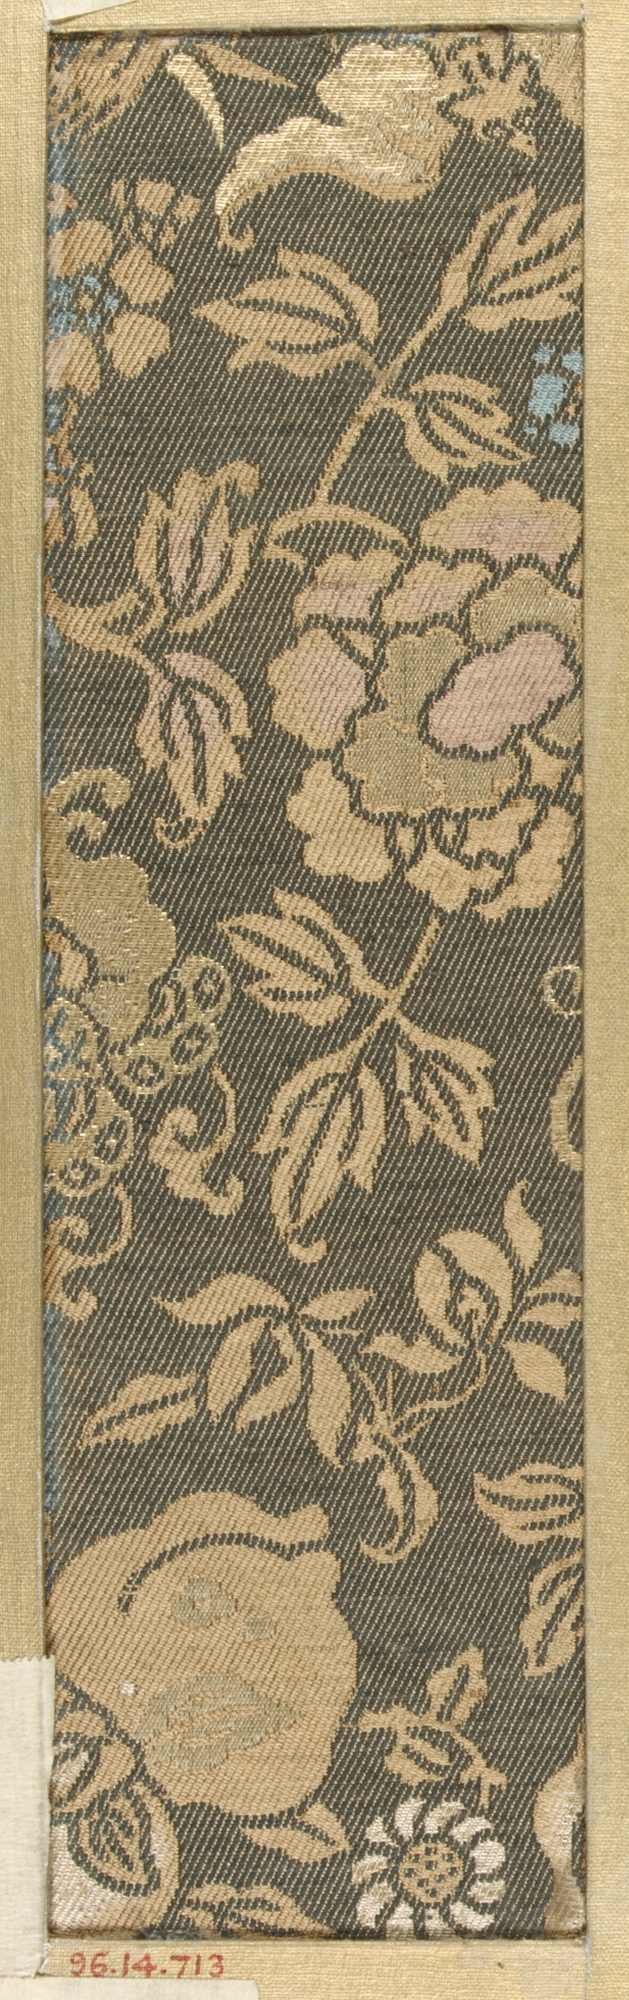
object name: piece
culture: japanese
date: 1701-1900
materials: silk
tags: leaves